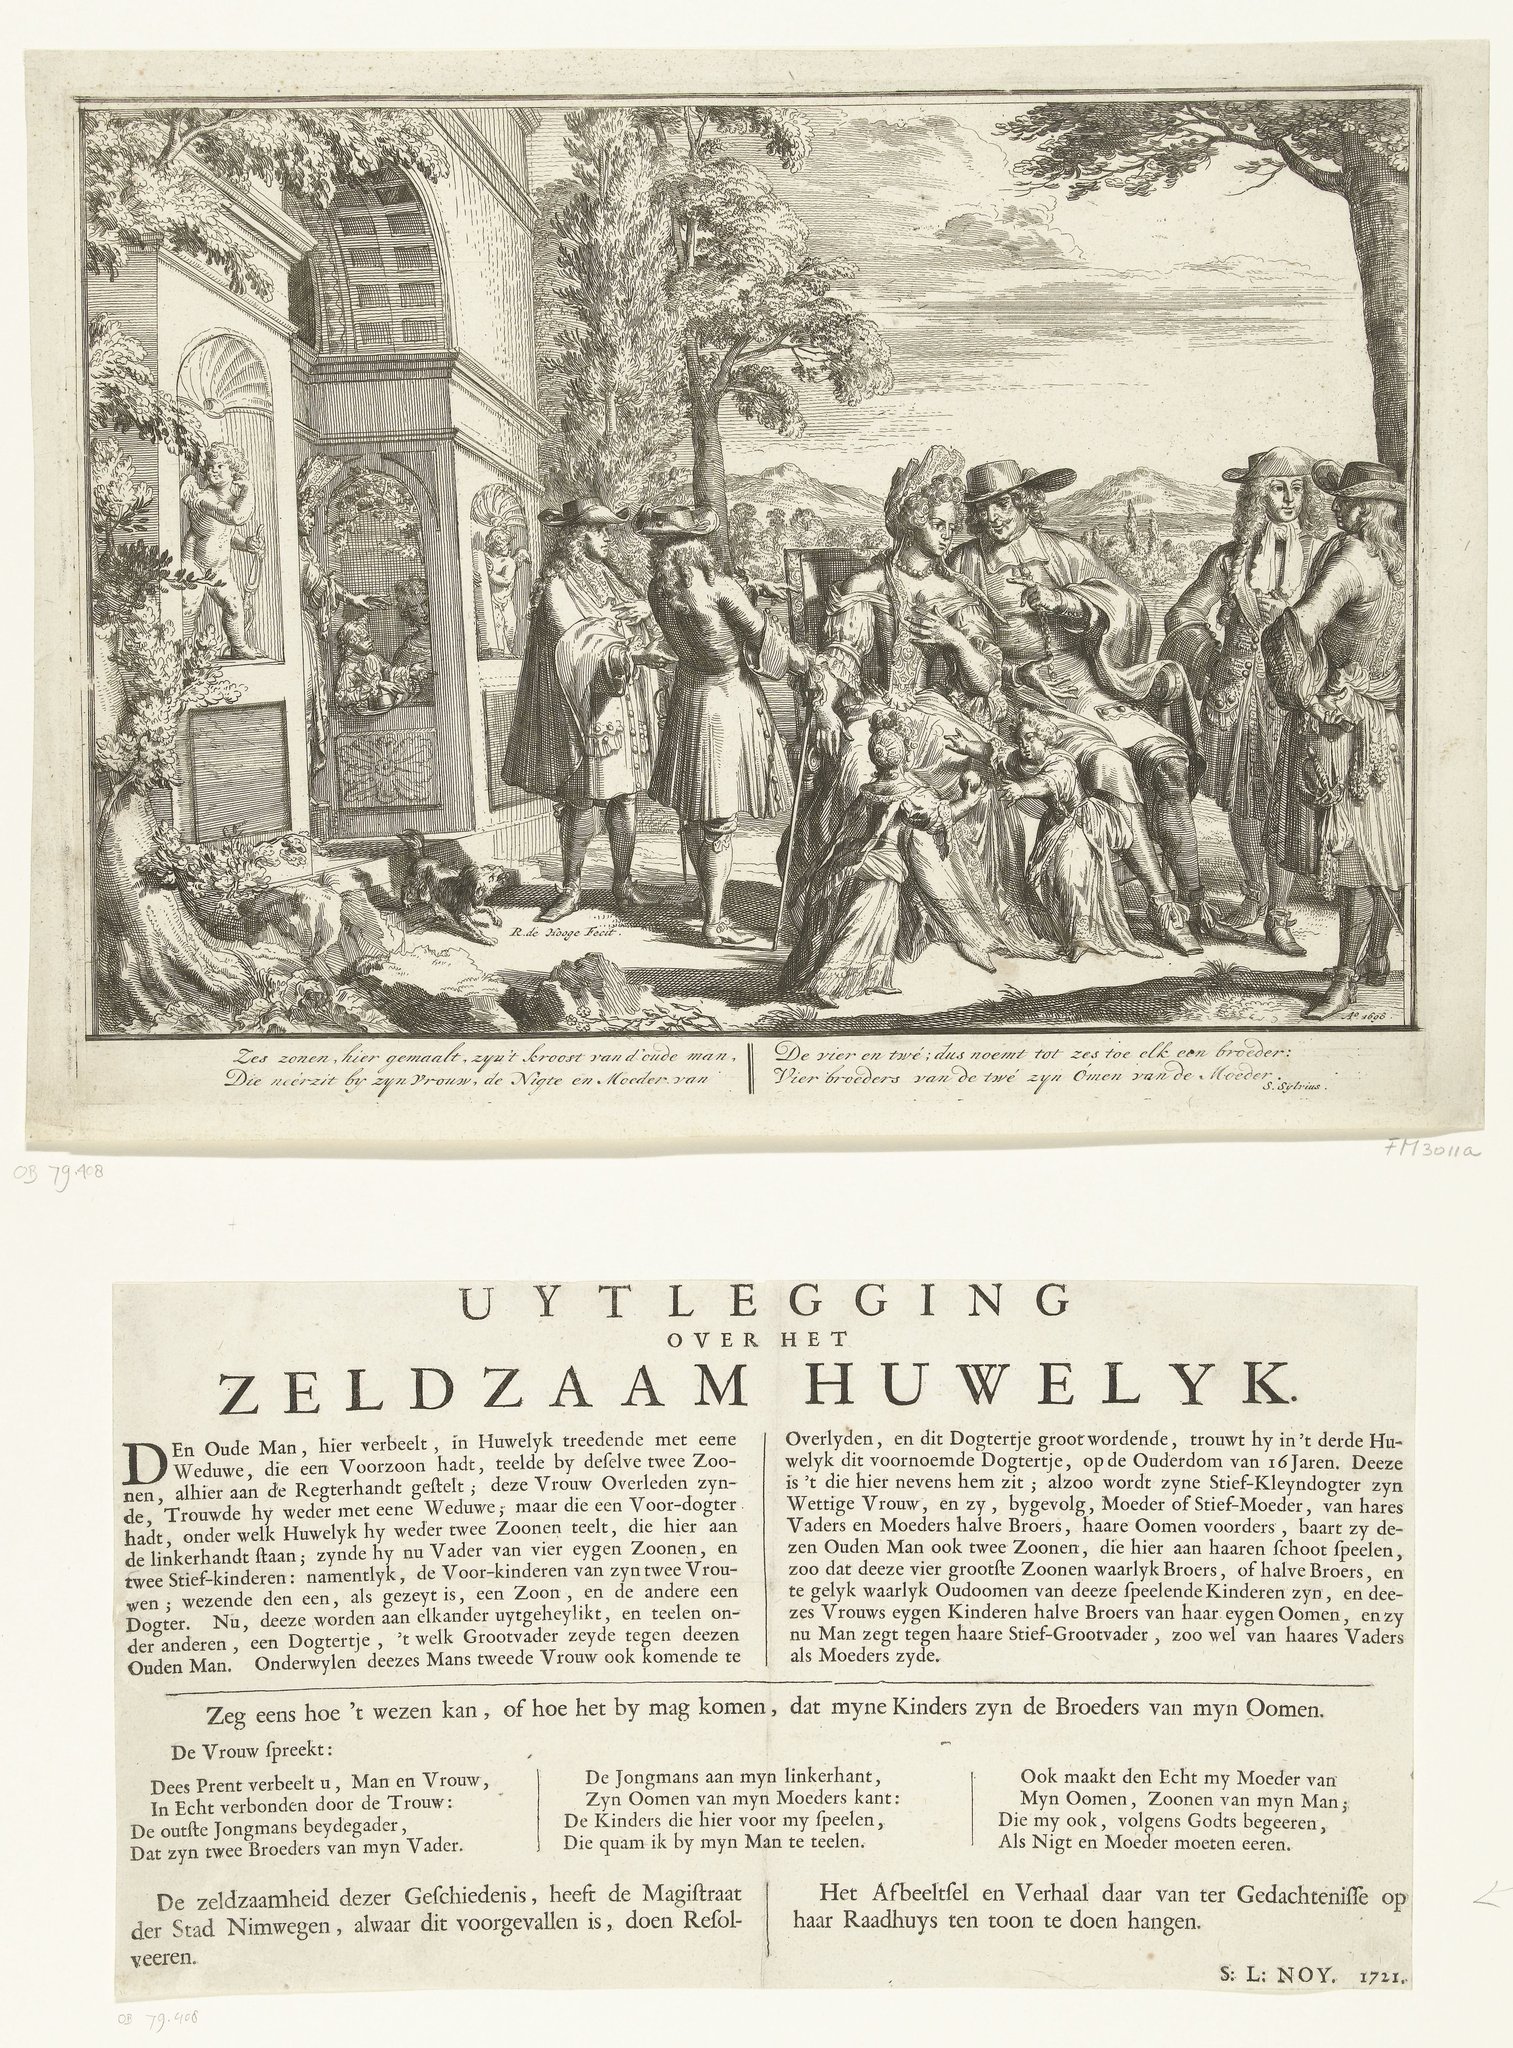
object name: print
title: Het Nijmeegse Raadsel of het Gecompliceerde Huwelijk, 1619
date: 1698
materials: paper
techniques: engraving, etching, letterpress printing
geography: northern netherlands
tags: picture, painting, family relationships (first, second, third and fourth degree), generations, nijmegen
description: Het Nijmeegse Raadsel of het Gecompliceerde Huwelijk, 1619. Schilderij hangende op het raadhuis van Nijmegen met een familieportret met ingewikkelde relaties afkomstig uit een huwelijk aldaar gesloten in 1618. Onder de voorstelling een vers van 2 keer 2 regels in het Nederlands. Hierbij ook een tekstblad met uitleg op de voorstelling.